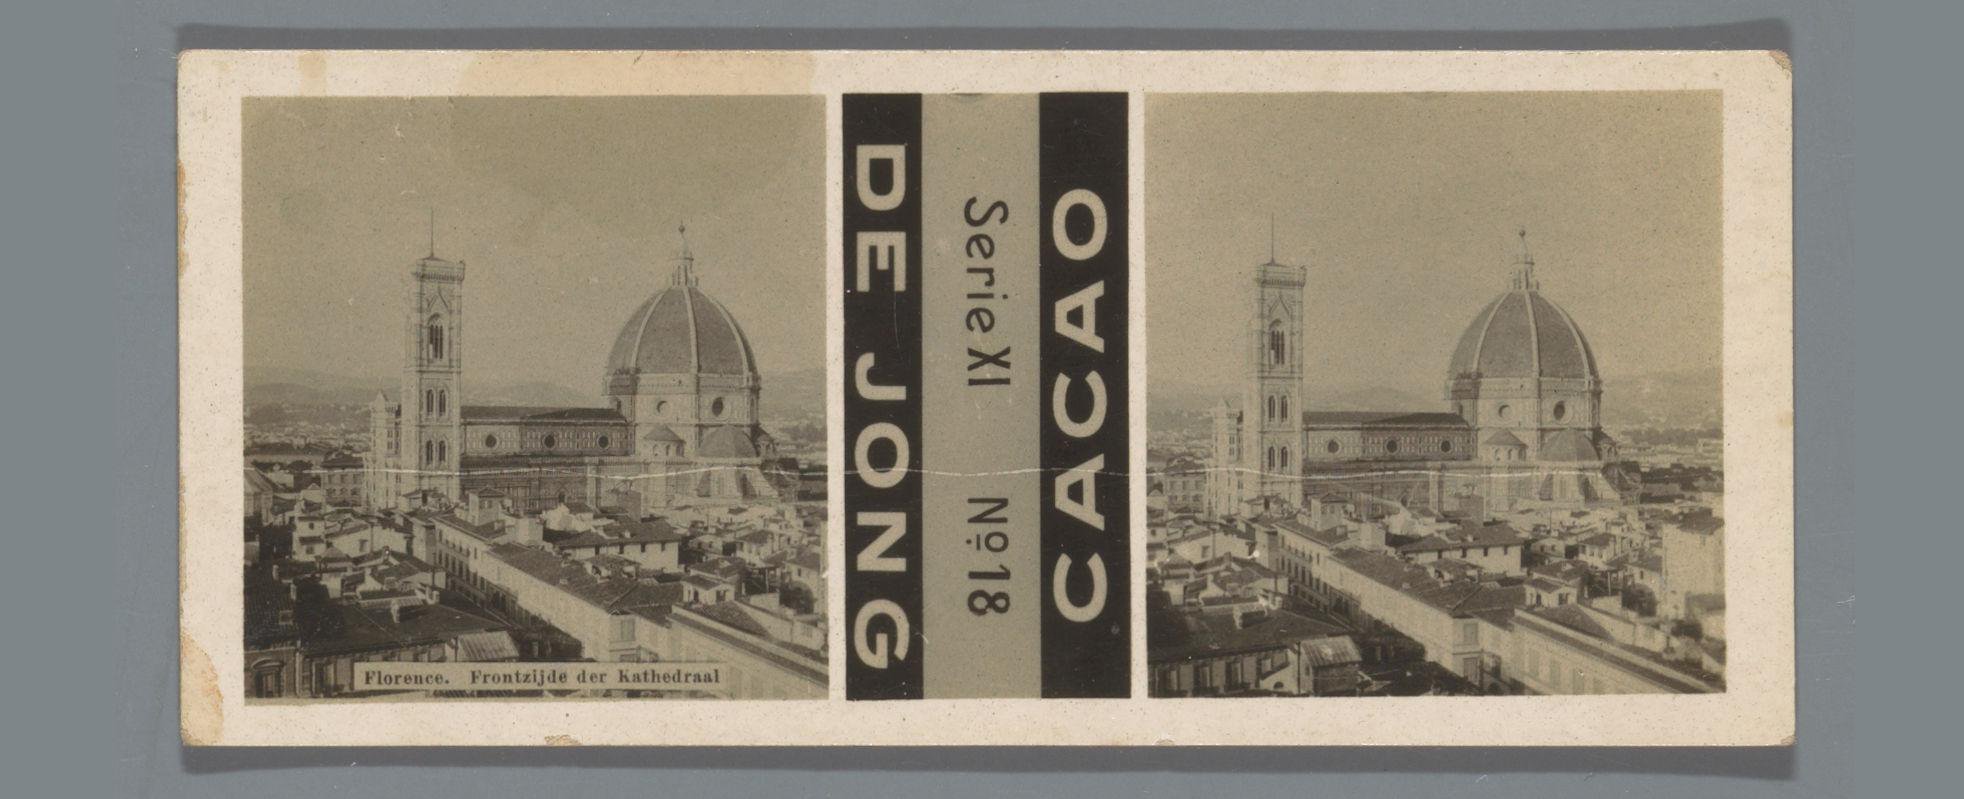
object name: stereograph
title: Gezicht op de Dom van Florence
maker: Anonymous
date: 1900-1910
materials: cardboard, photographic support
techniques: gelatin silver print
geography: florence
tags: parts of church exterior and annexes: dome, church (exterior), façade (of house or building)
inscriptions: number: ‘Serie IX No. 20’, inscription: ‘De Jong Cacao’